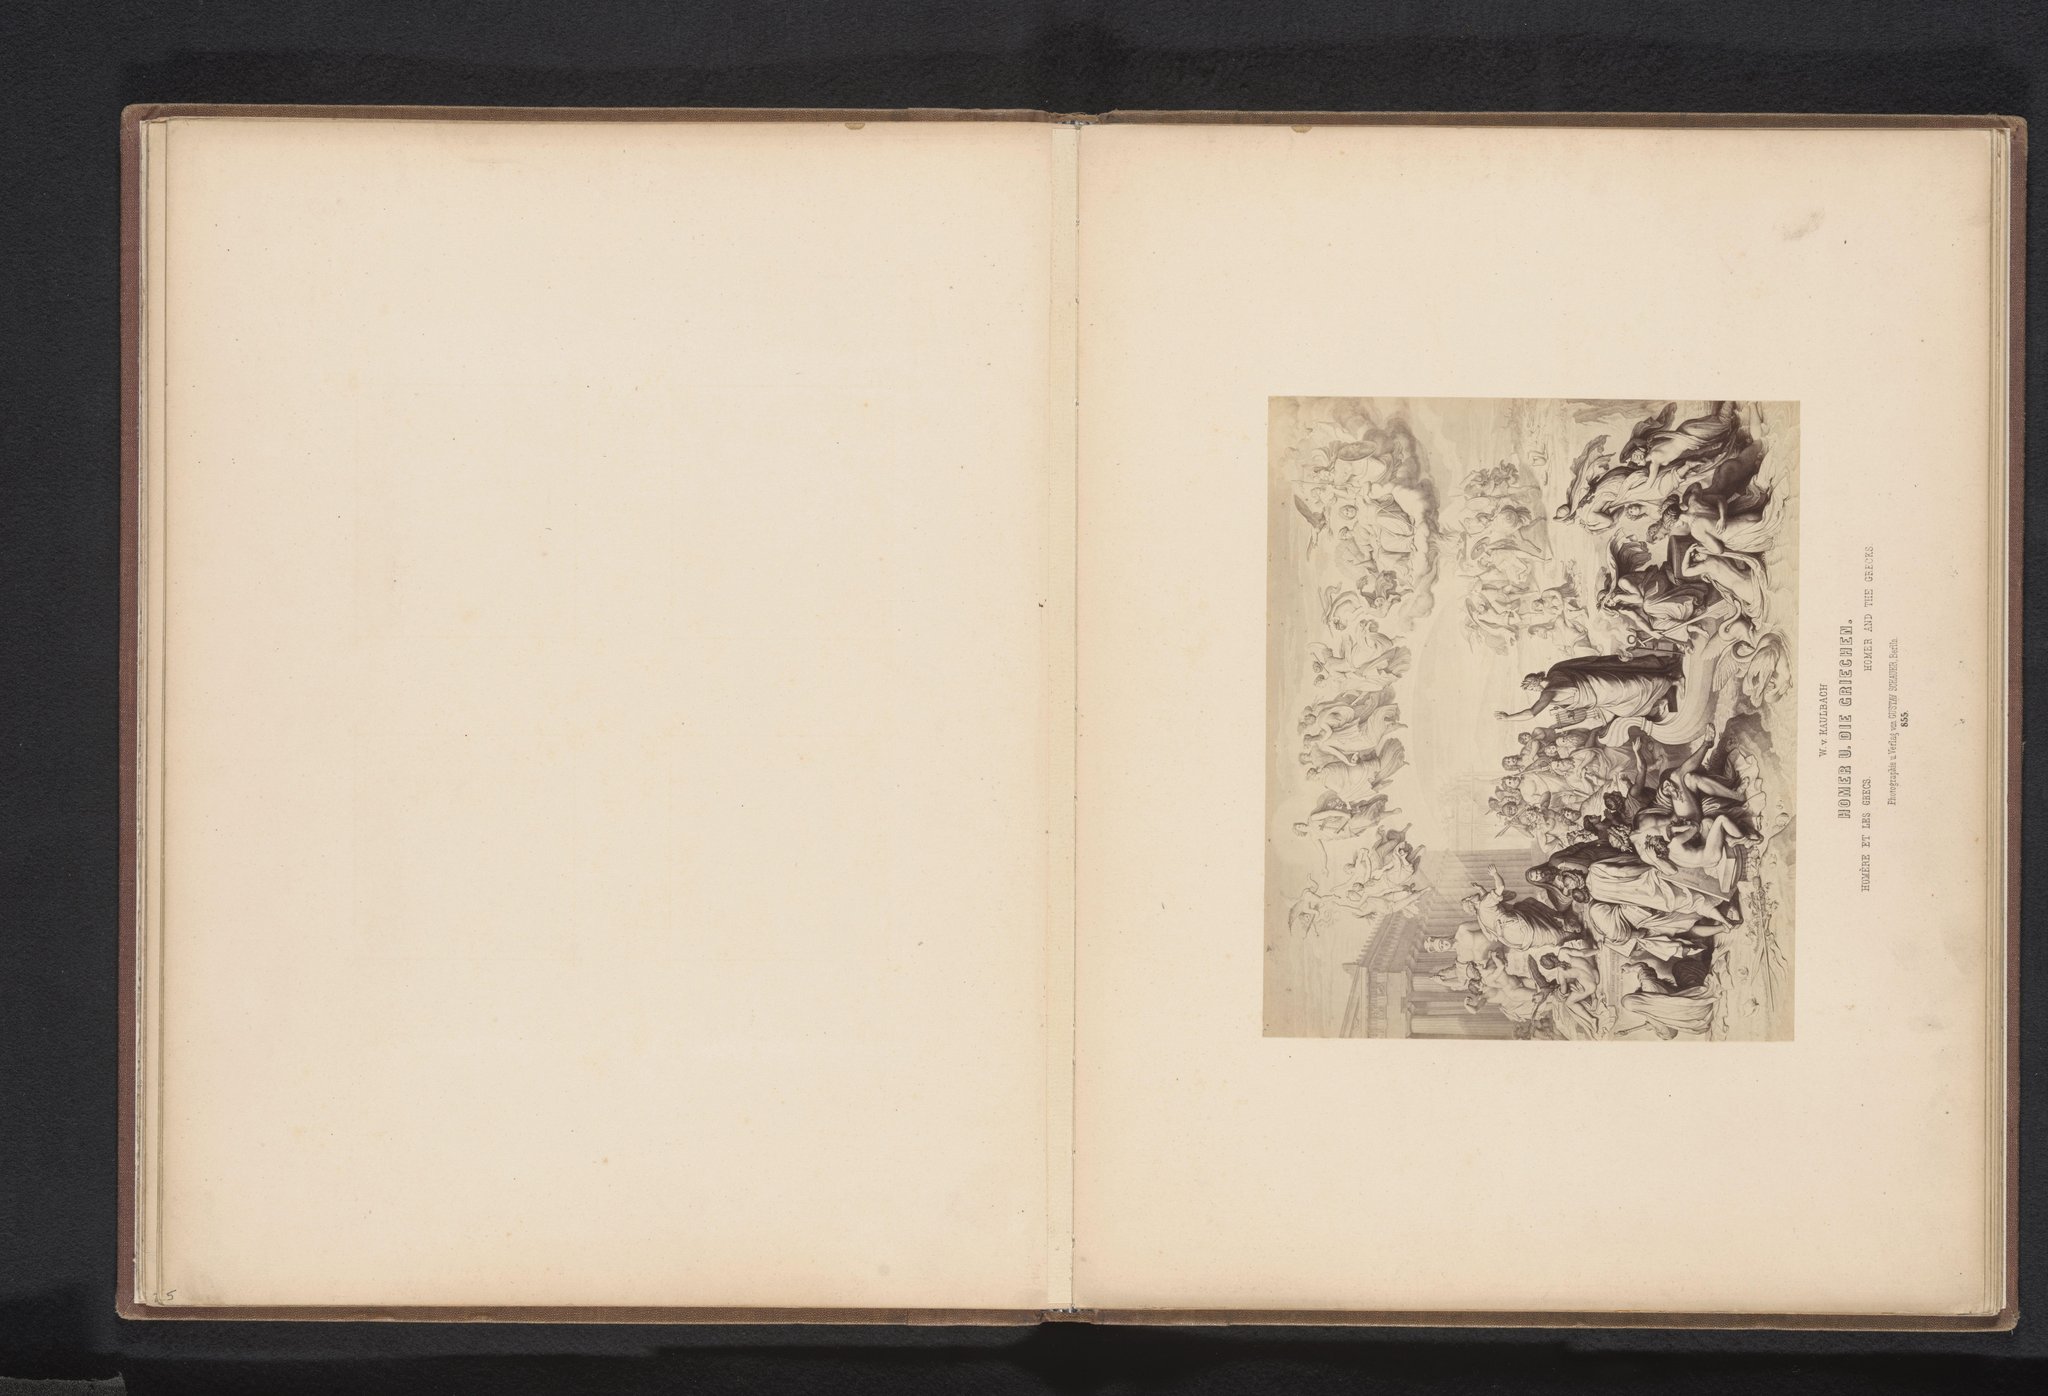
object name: page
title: Homer u. die Griechen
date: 1860-1870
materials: photographic support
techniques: albumen print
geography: berlin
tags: wall-covering, (story of) homer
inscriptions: number: ‘855.’